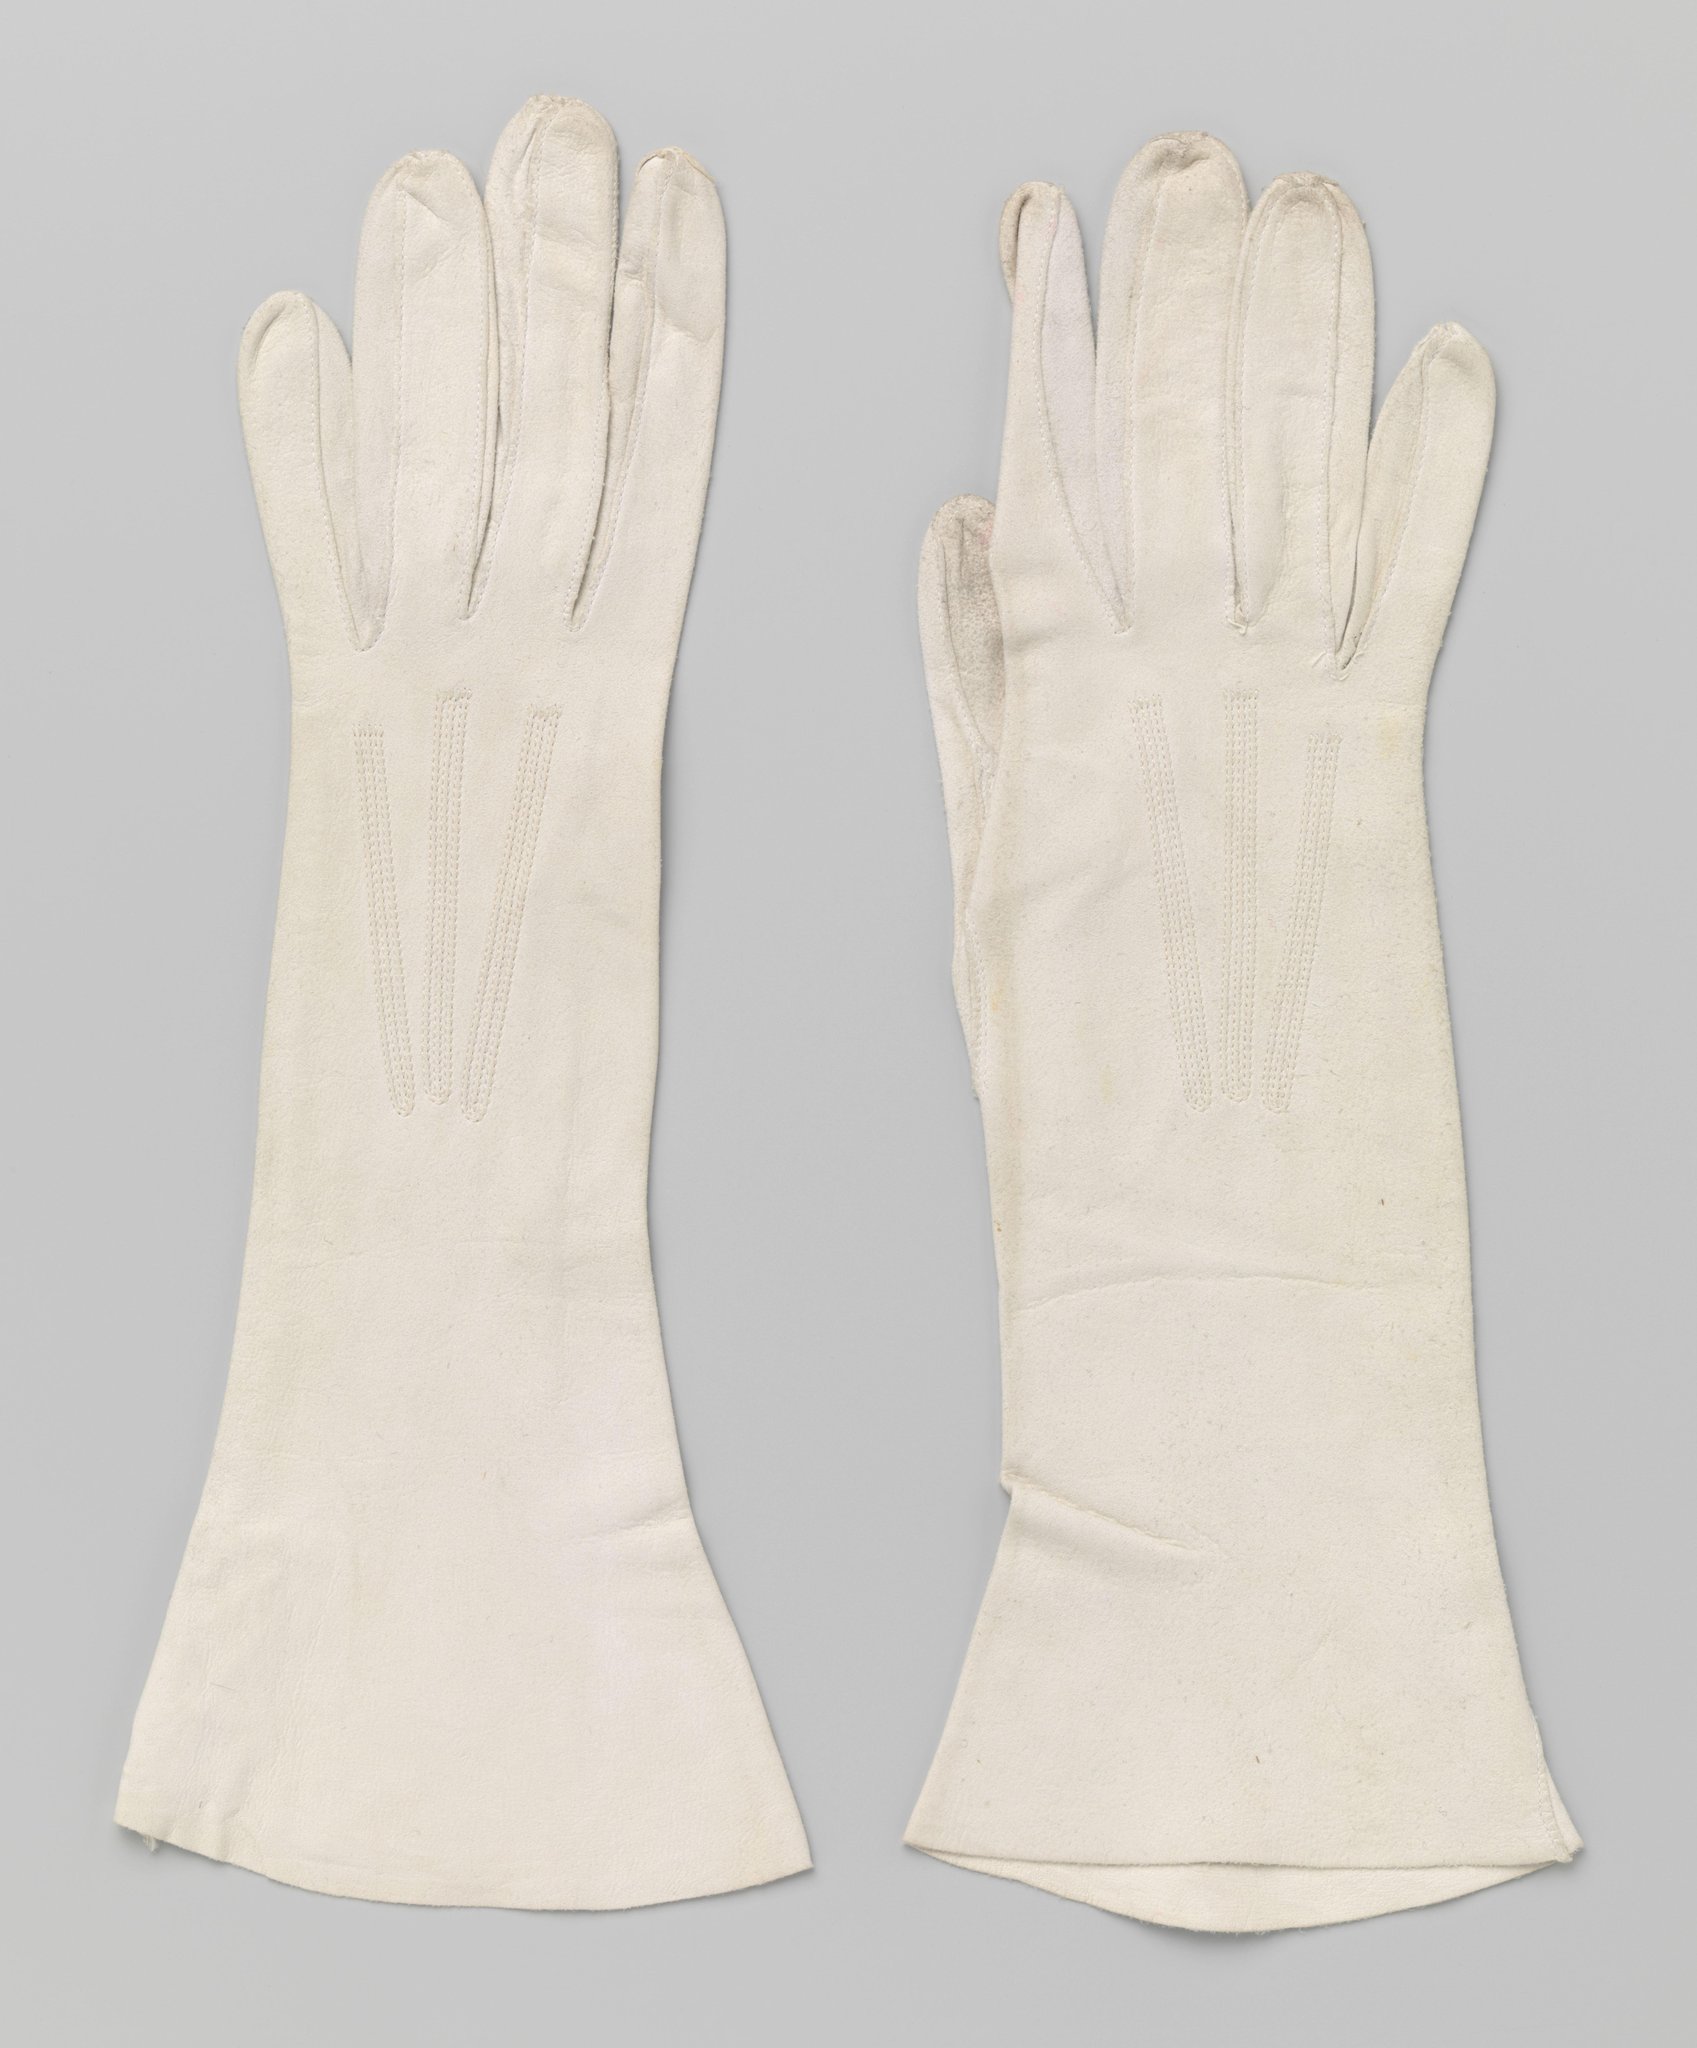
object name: glove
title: Handschoen van grijs, beige zeemleer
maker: Anonymous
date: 1900-1915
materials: leather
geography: western europe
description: Rechterhandschoen van grijs, beige zeemleer. Op de rug drie uitstralende koorden.